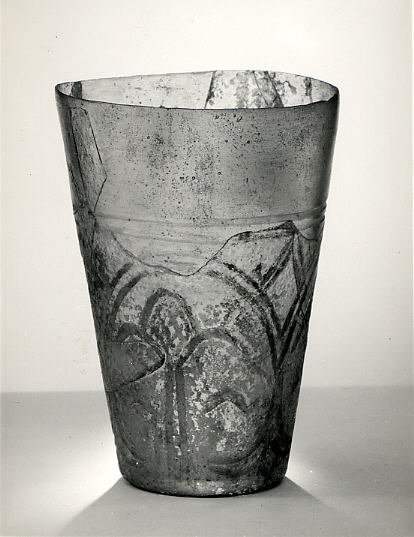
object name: cup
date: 901-1000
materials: glass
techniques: cutting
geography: iran